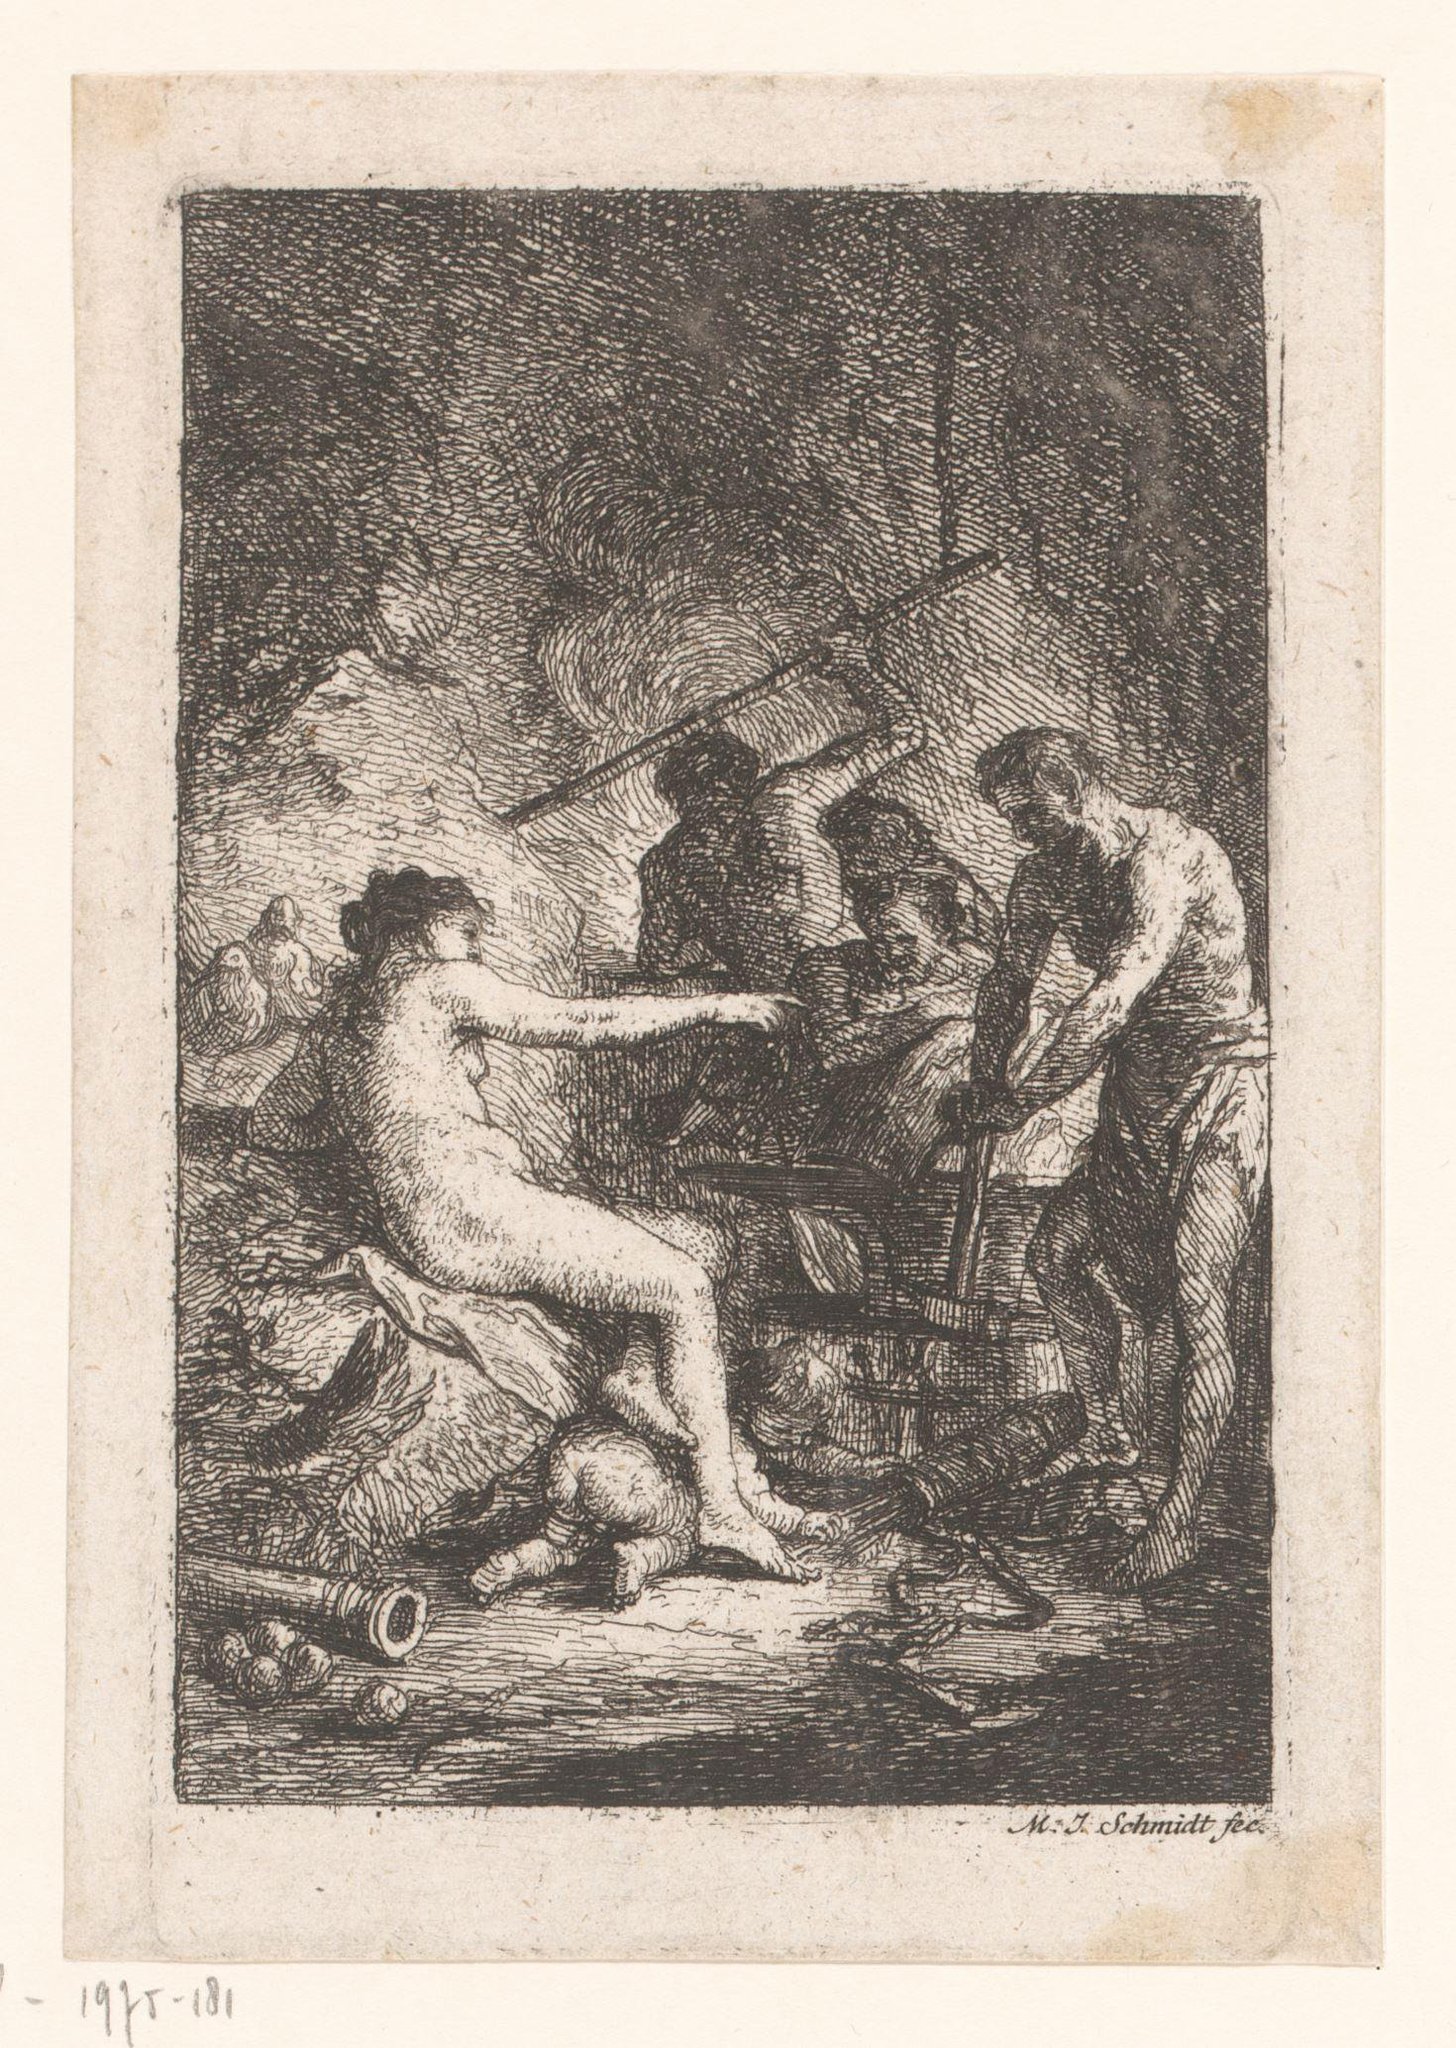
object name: print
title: Venus in de smidse van Vulcanus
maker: martin johann schmidt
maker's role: draughtsman, print maker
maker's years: 1718-1801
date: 1771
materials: paper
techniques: etching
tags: (story of) vulcan (hephaestus)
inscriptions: collector's mark: Lugt 2760, collector's mark: Lugt 2228